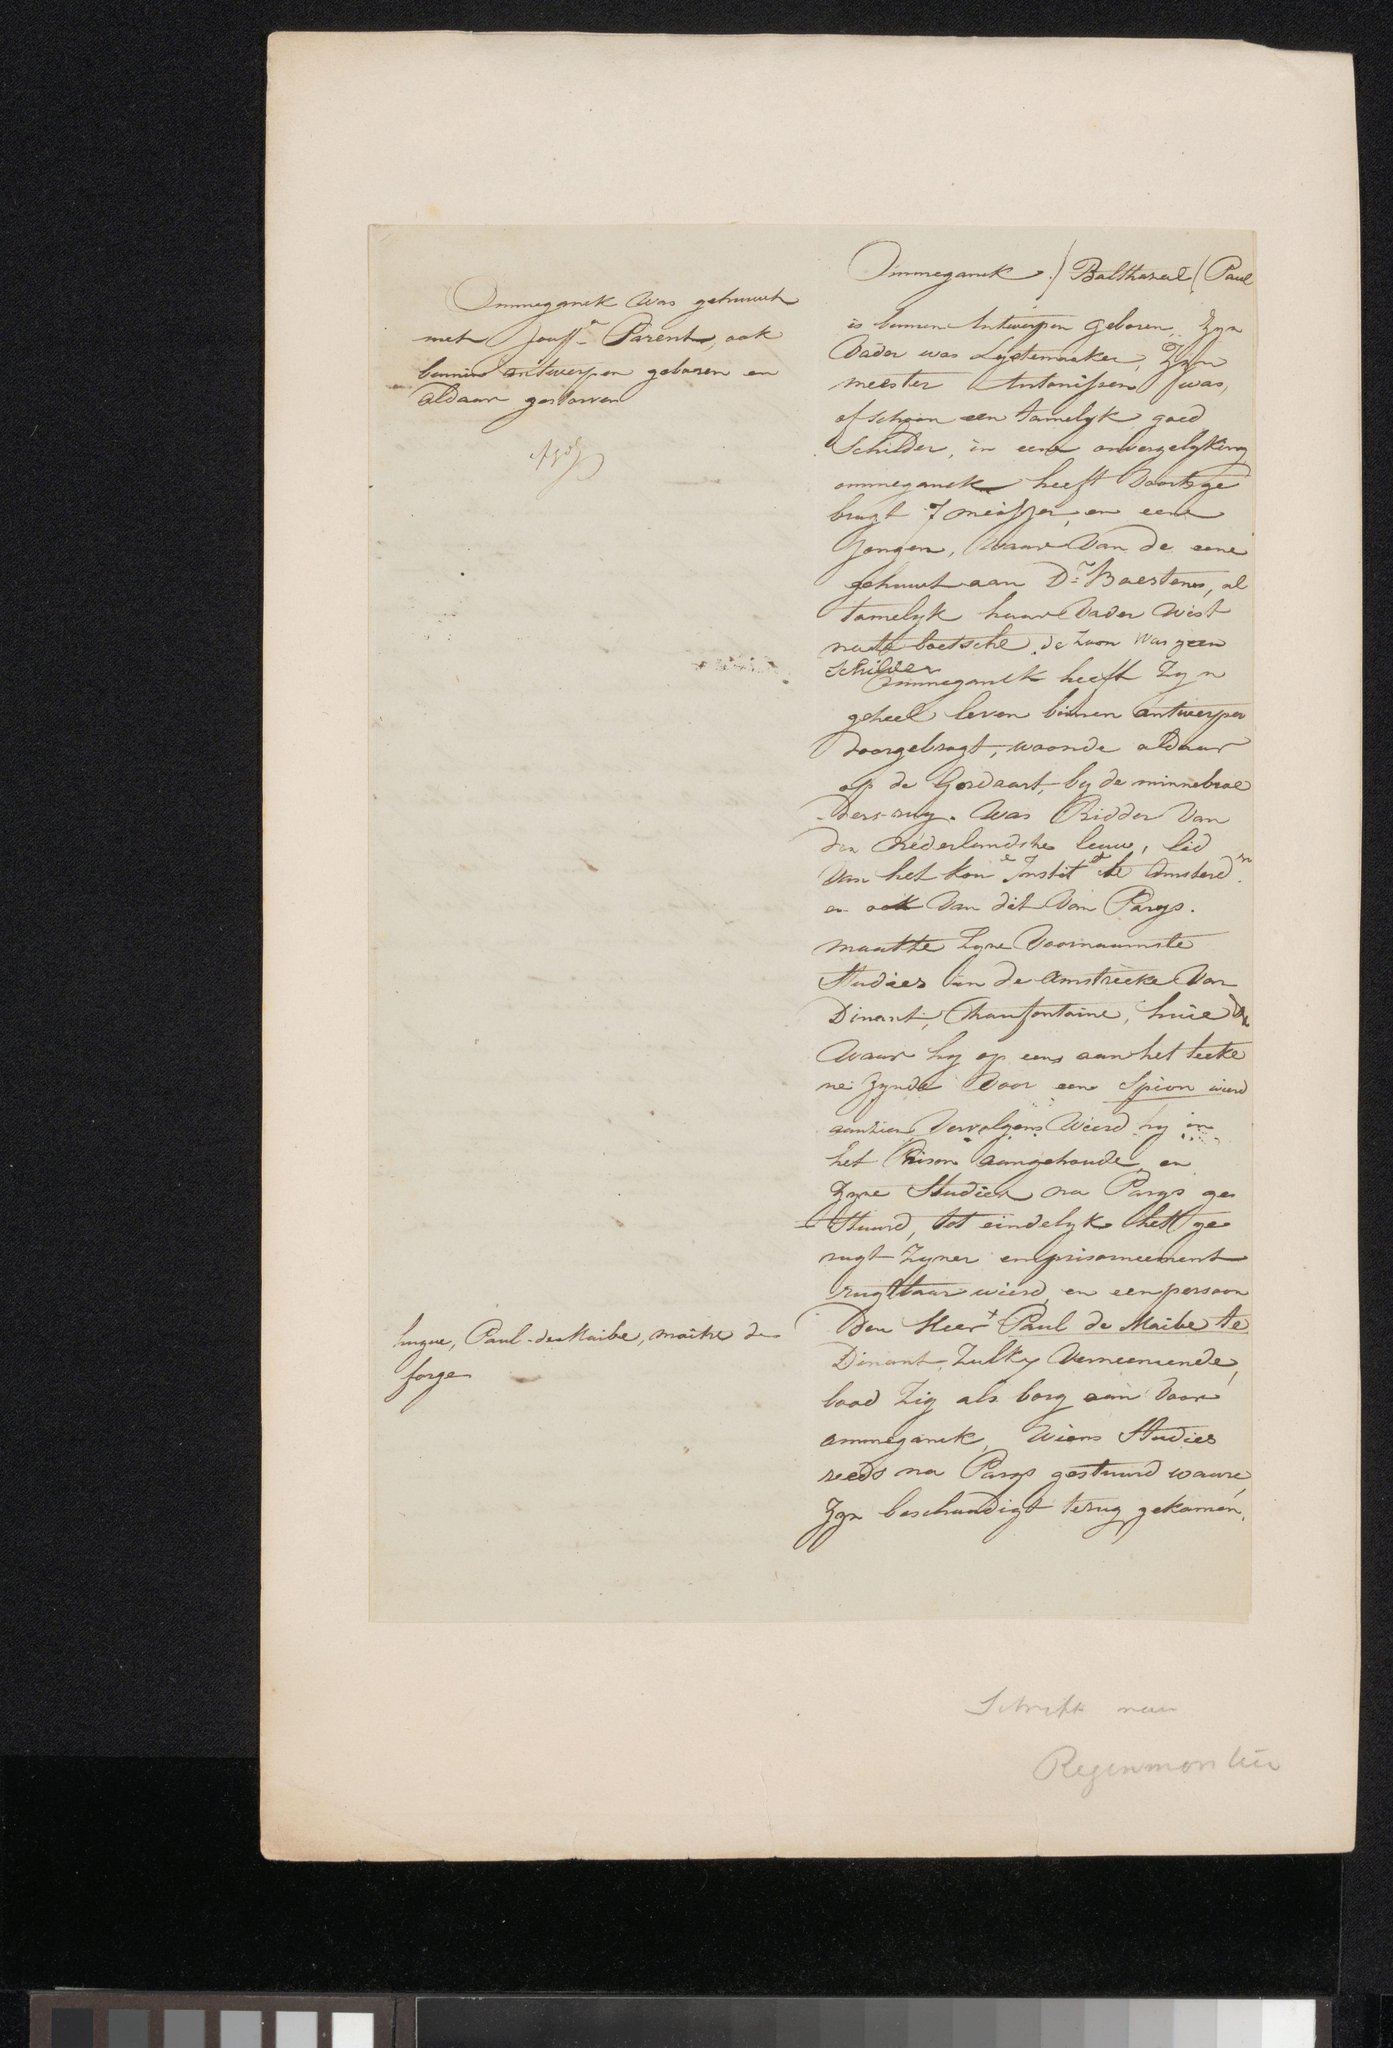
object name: manuscript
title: Handschrift betreffende Balthasar Paul Ommeganck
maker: ignatius josephus van regemorter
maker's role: conservator, painter, print maker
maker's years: 1785-1873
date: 1795-1873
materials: ink, paper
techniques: pen, writing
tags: draughtsman, balthasar paul ommeganck, painting (including book-illumination, miniature-painting)